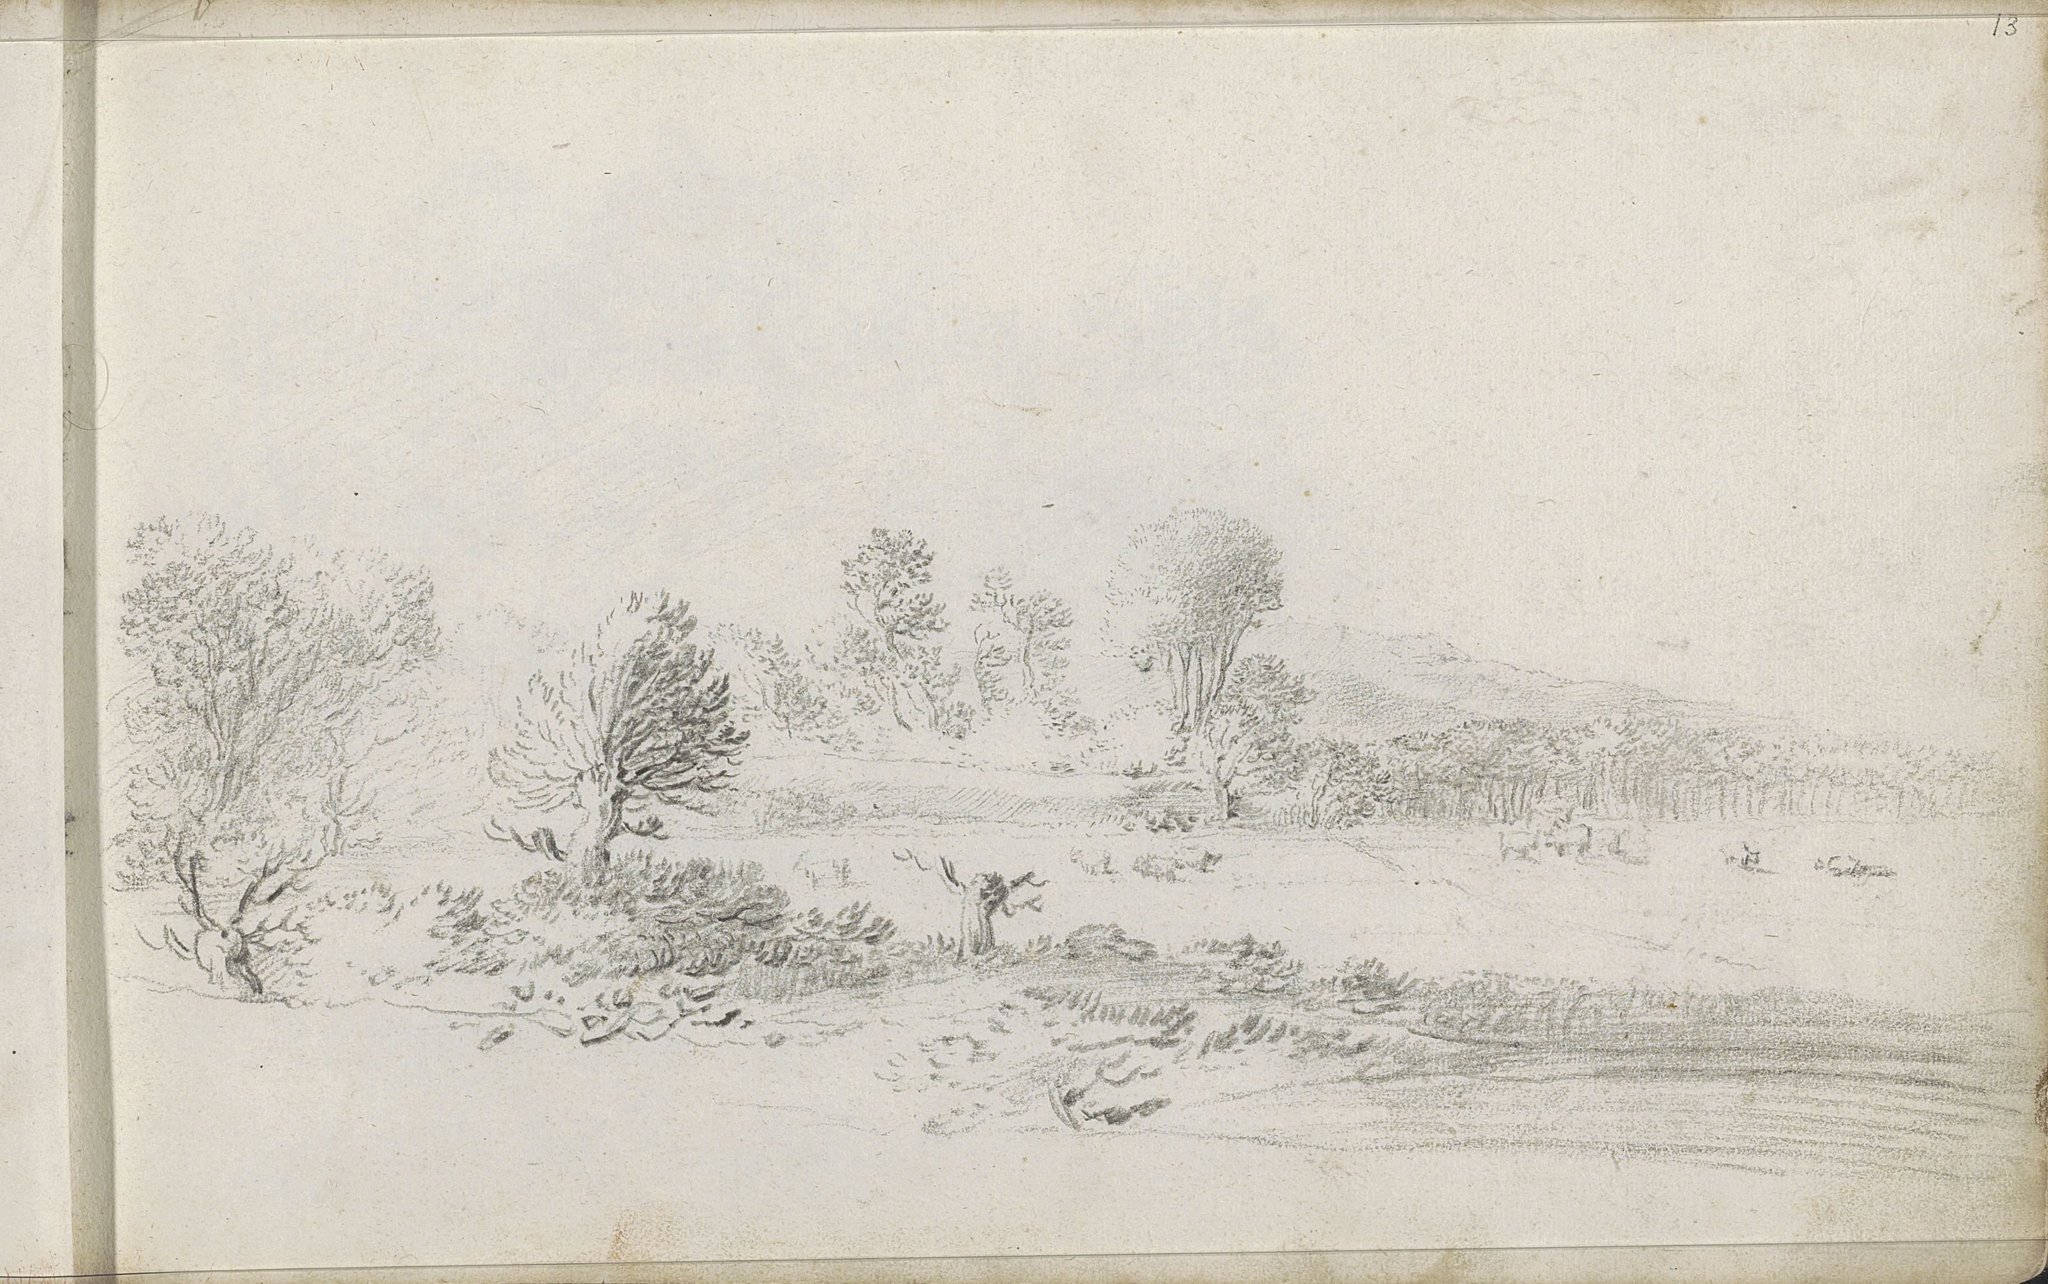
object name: sketchbook leaf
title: Heuvellandschap met een weiland en knotwilgen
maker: pieter moninckx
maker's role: draughtsman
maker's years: 1606-1686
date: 1645-1646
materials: chalk, paper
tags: low hill country, trees: pollard willow, cattle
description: Blad 13 recto uit een schetsboek met 39 bladen.